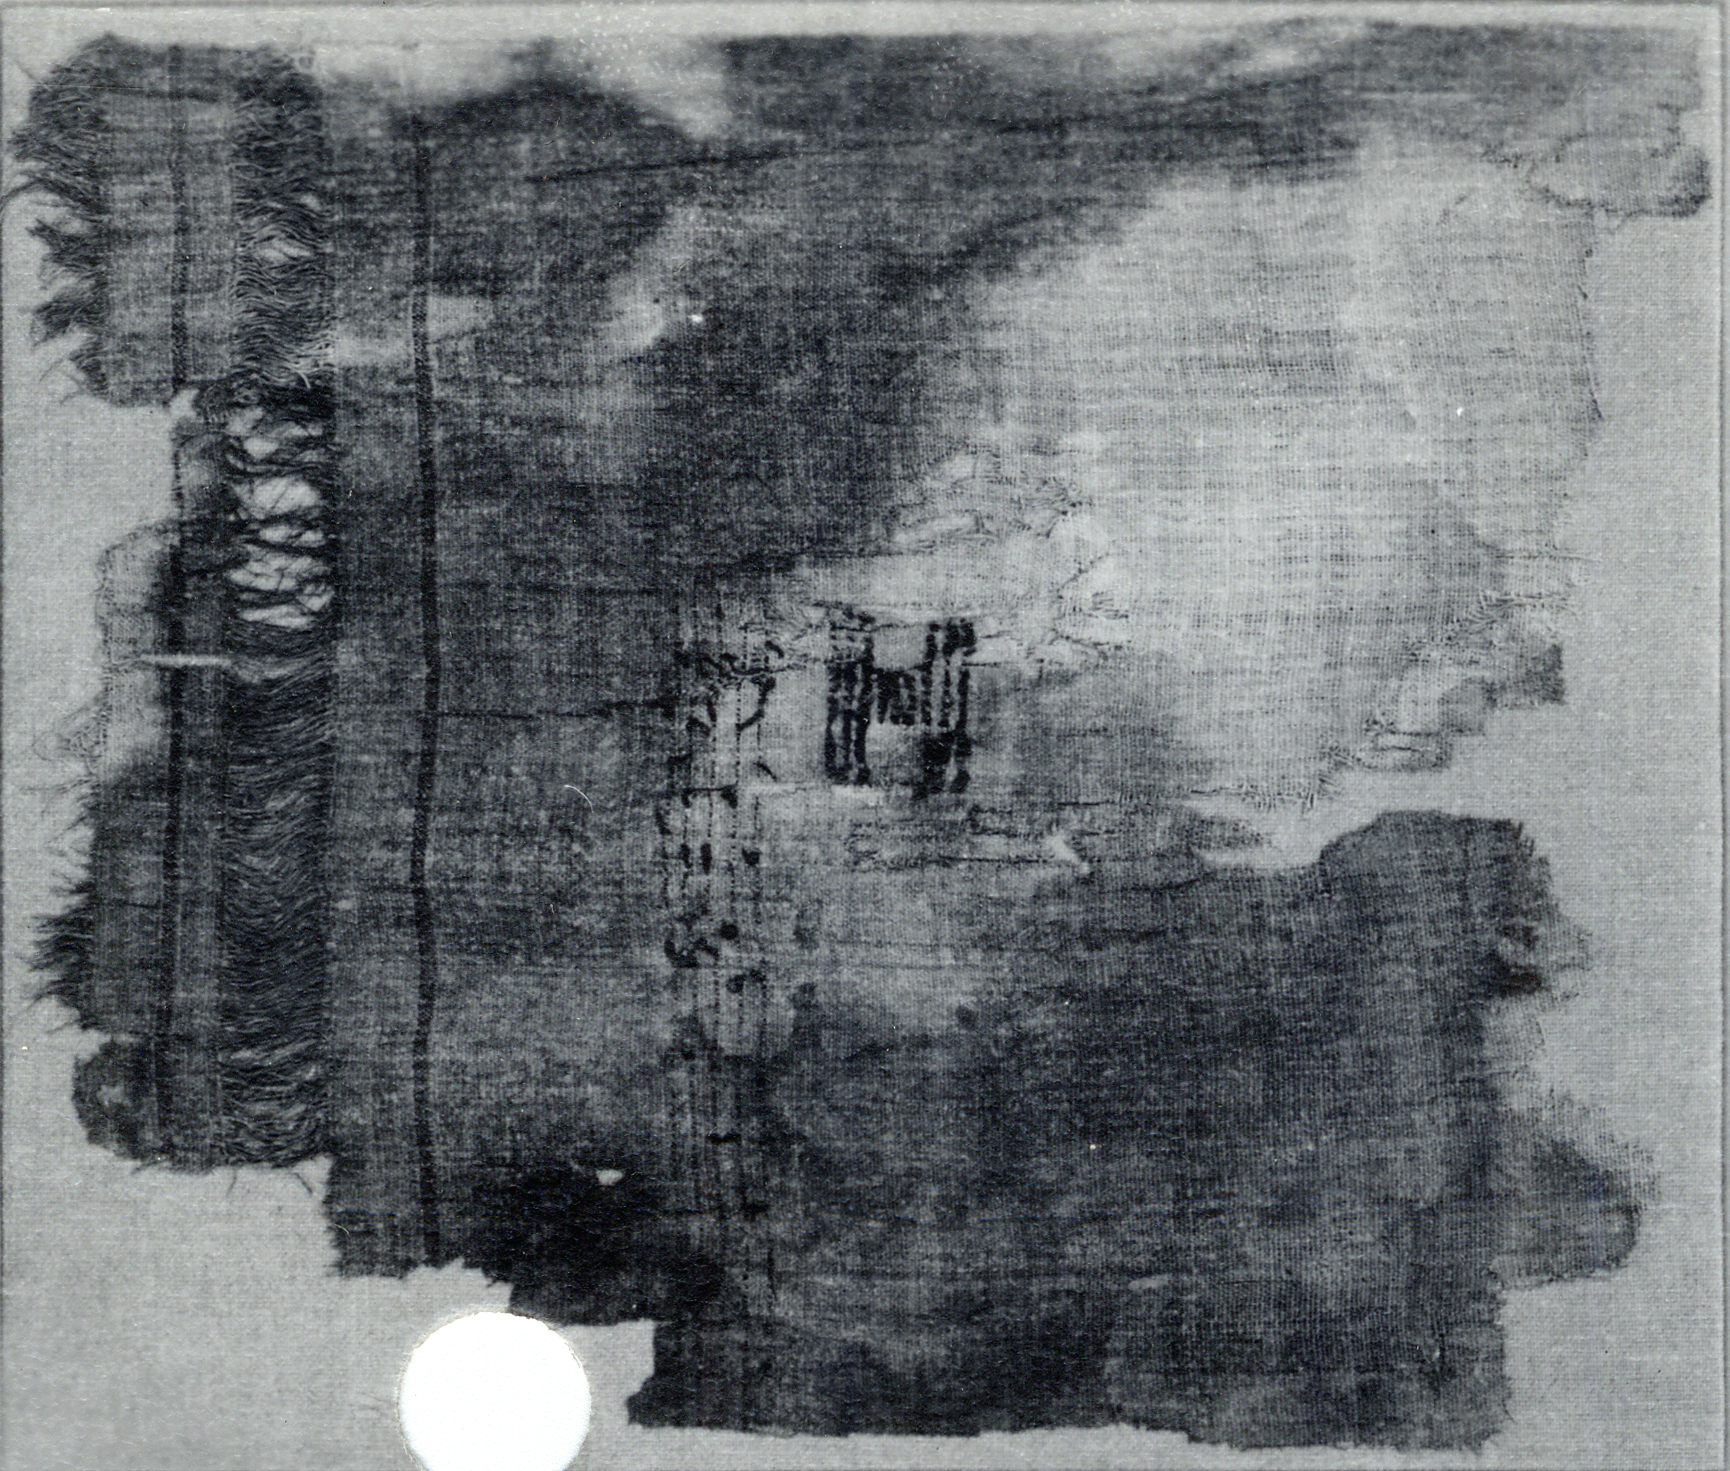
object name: fragment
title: Sheet Fragment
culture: coptic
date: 301-400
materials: linen, wool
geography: egypt